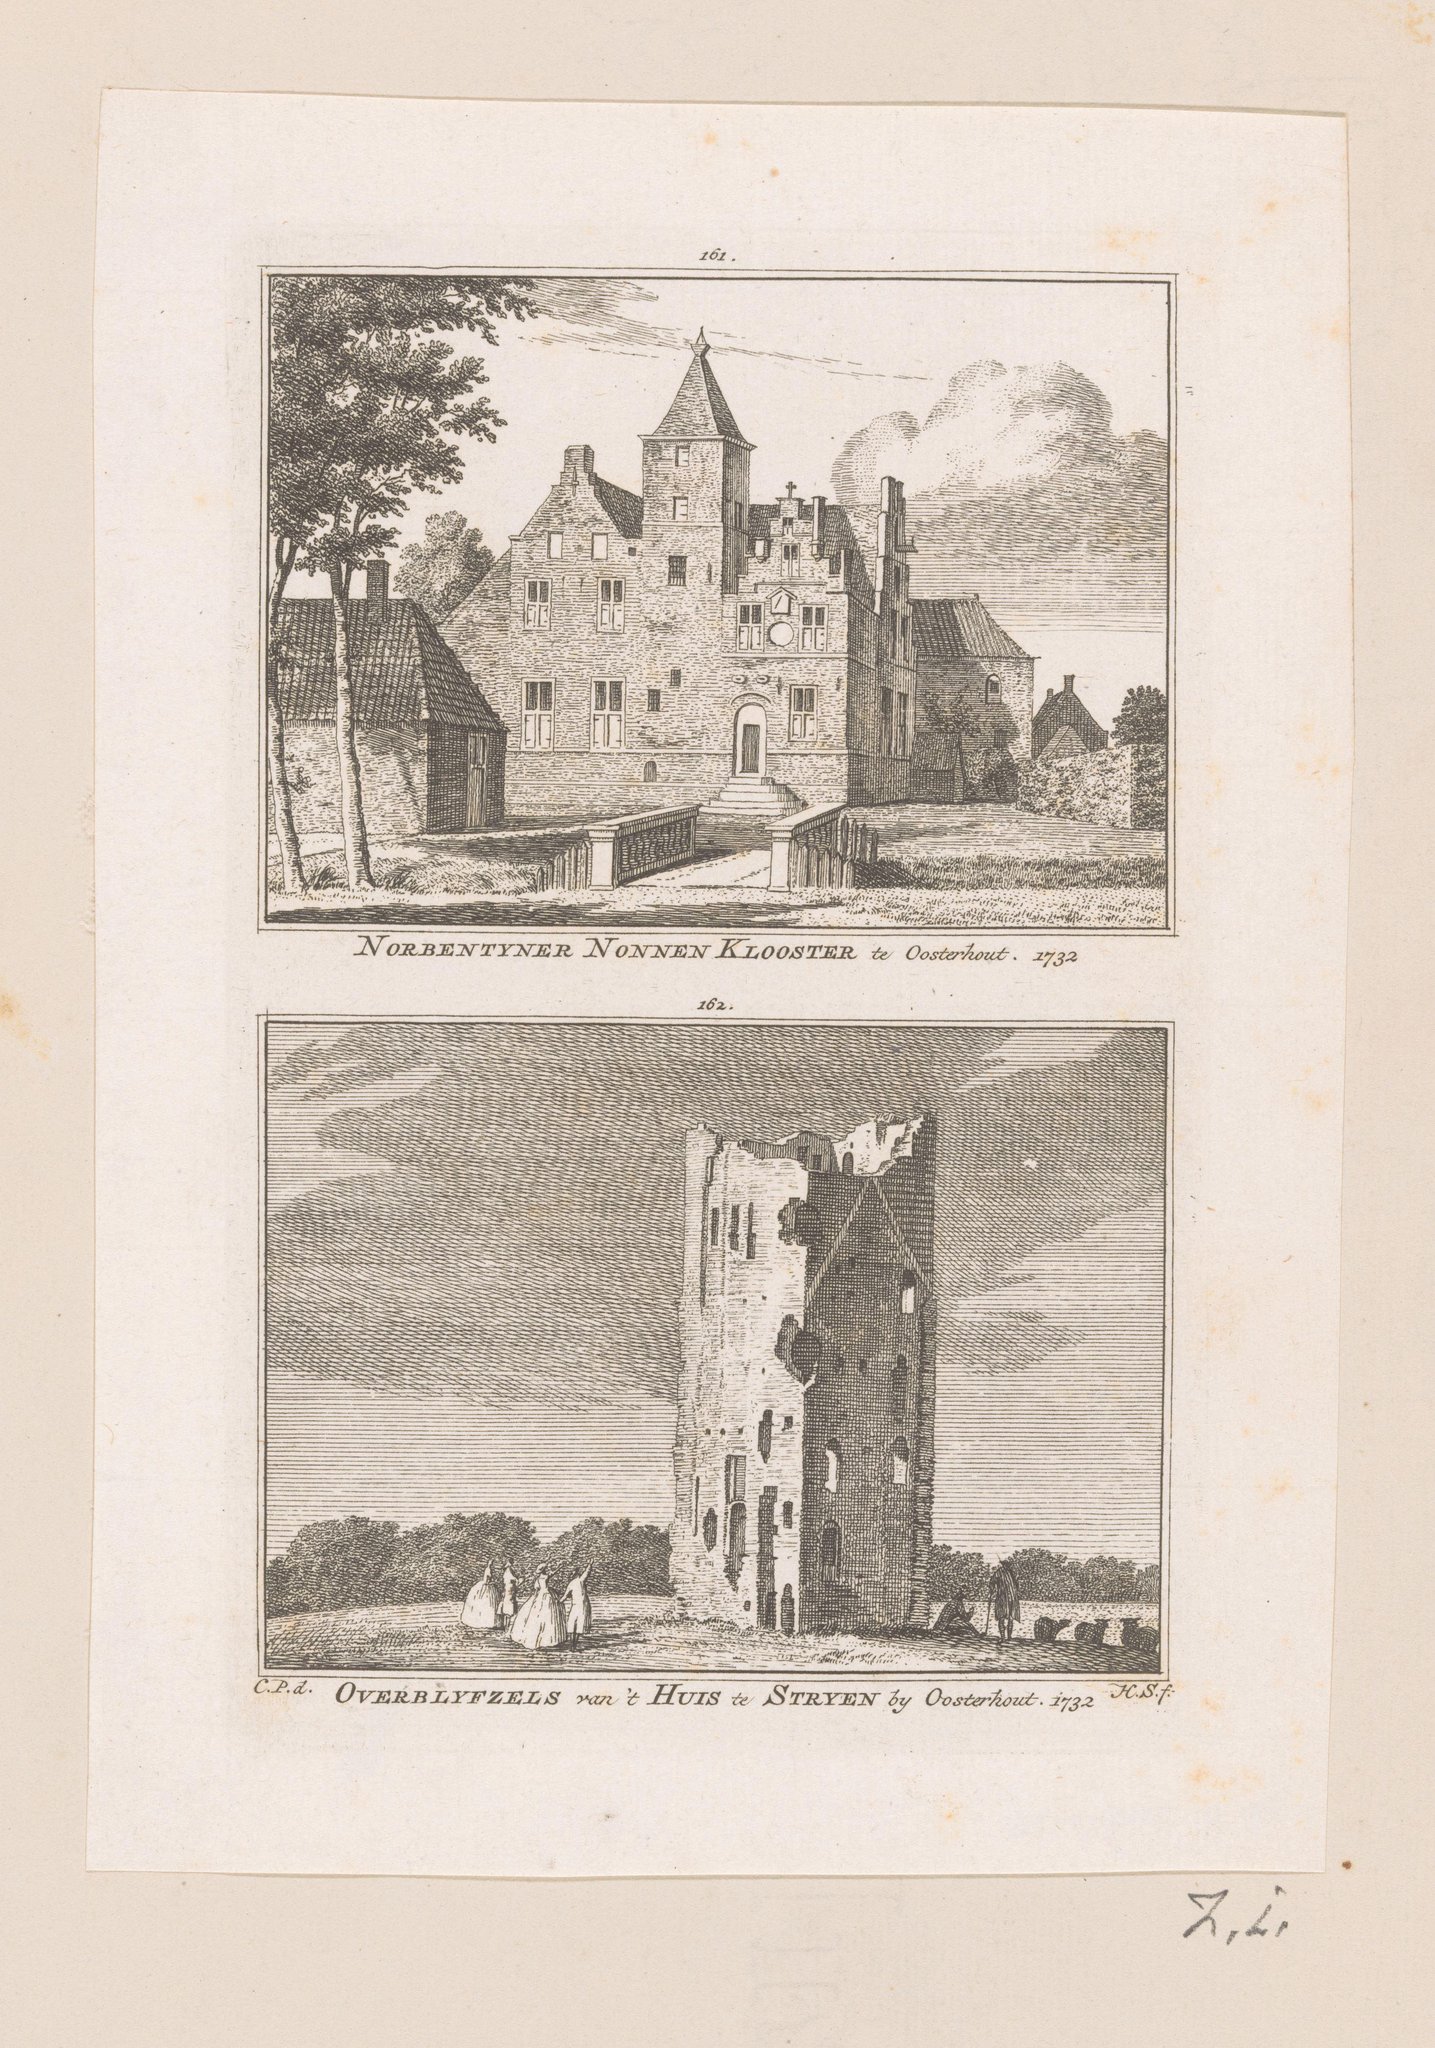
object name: book illustration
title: Overblyfzels van 't Huis te Stryen bij Oosterhout. 1732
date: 1746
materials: paper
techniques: engraving, etching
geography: amsterdam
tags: abbey, monastery, convent ~ roman catholic church, ruin of a dwelling, house, castle, etc.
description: Prent uit: Spilman, Hendrik. Het verheerlykt Nederland, of kabinet van hedendaagsche gezigten. 9 dln. Amsterdam: Isaac Tirion, 1745-1774, dl. 2 (1746).